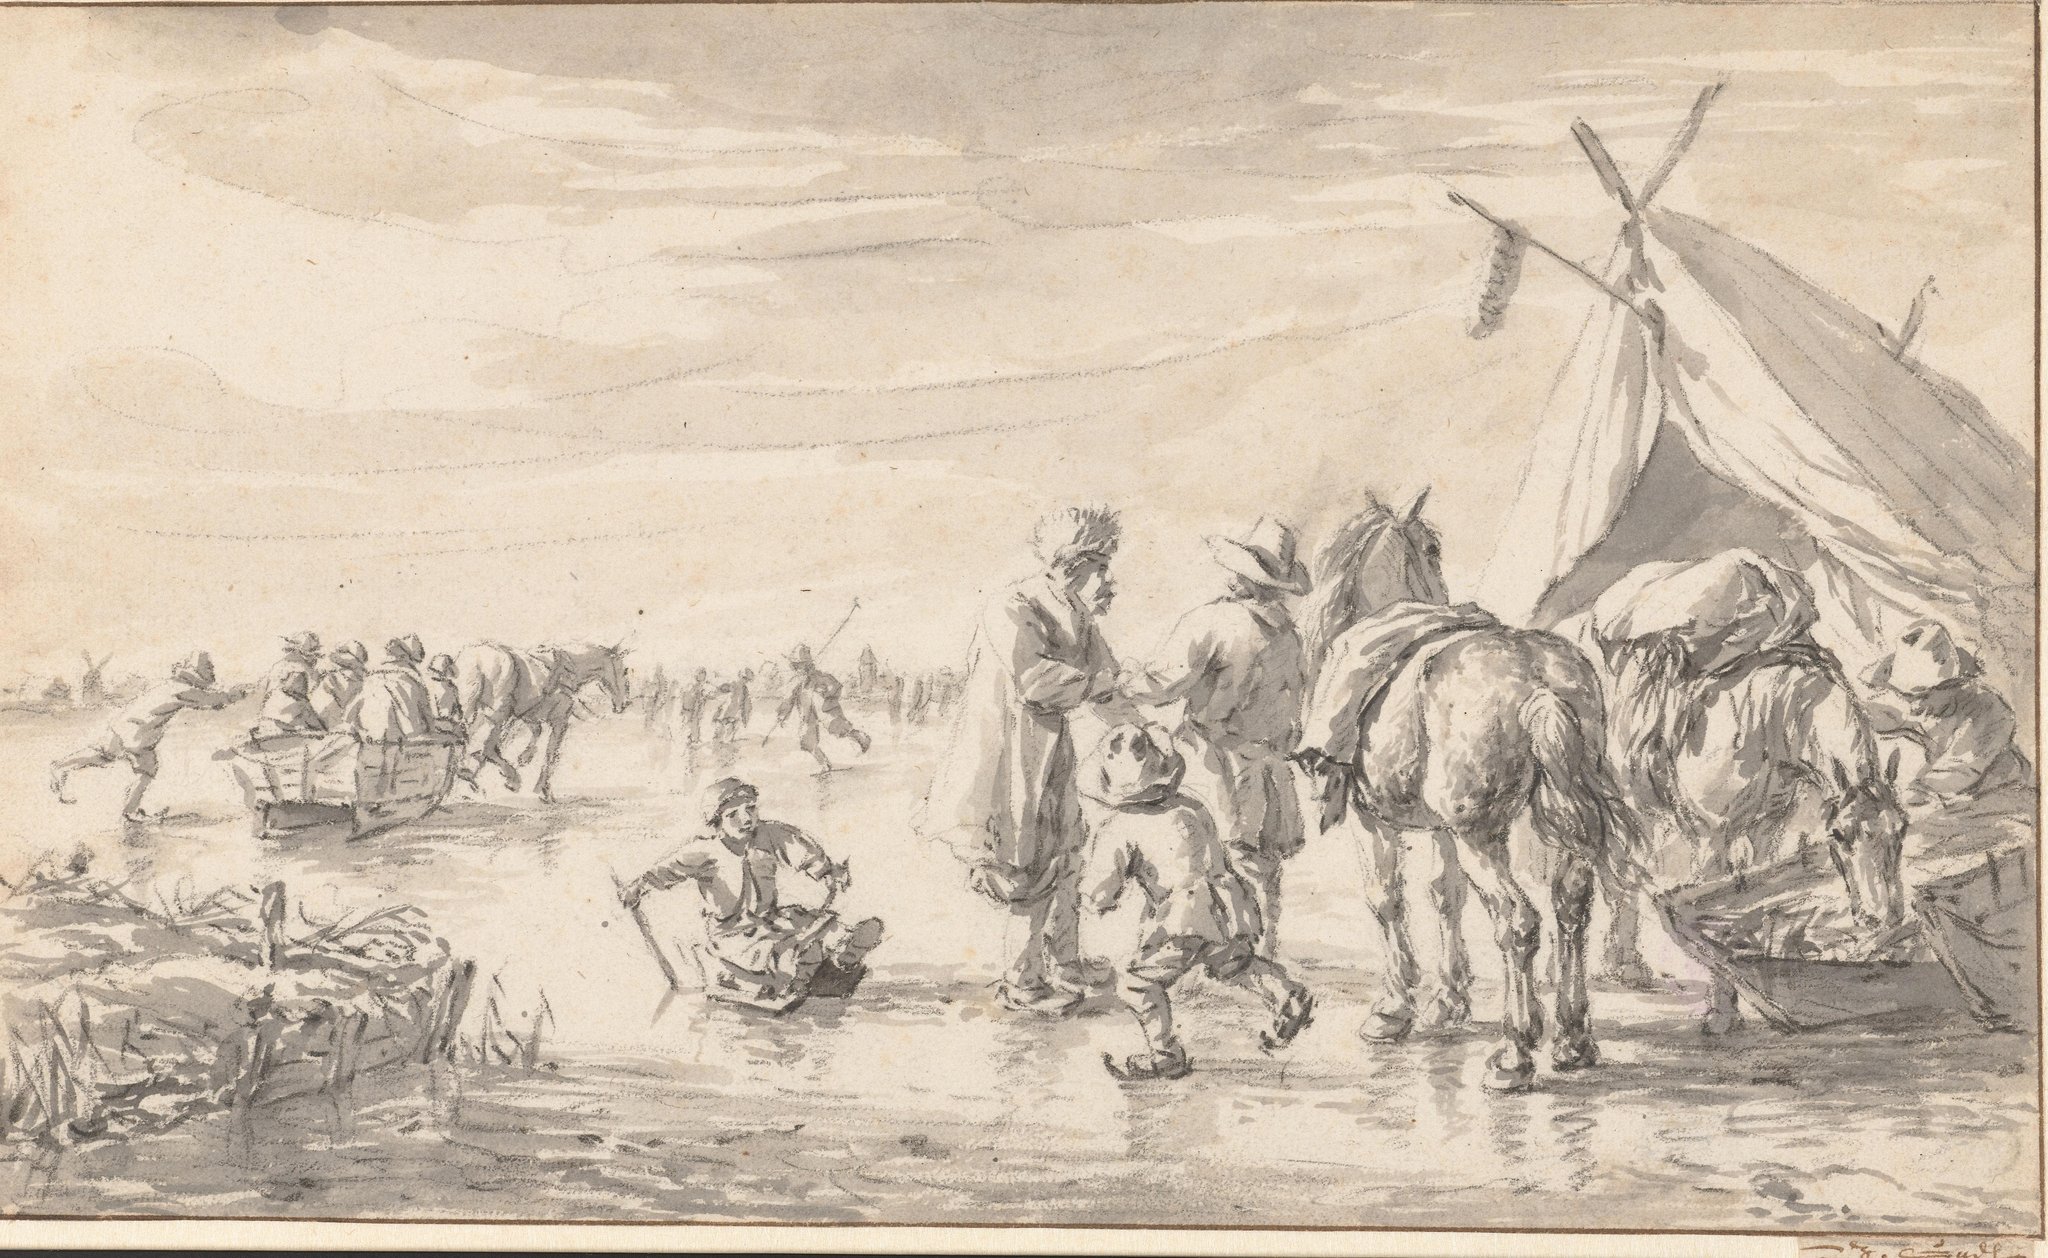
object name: drawing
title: Ice Scene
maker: barent gael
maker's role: draughtsman, painter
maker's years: 1630-1698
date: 1640-1673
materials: chalk, paper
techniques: brush